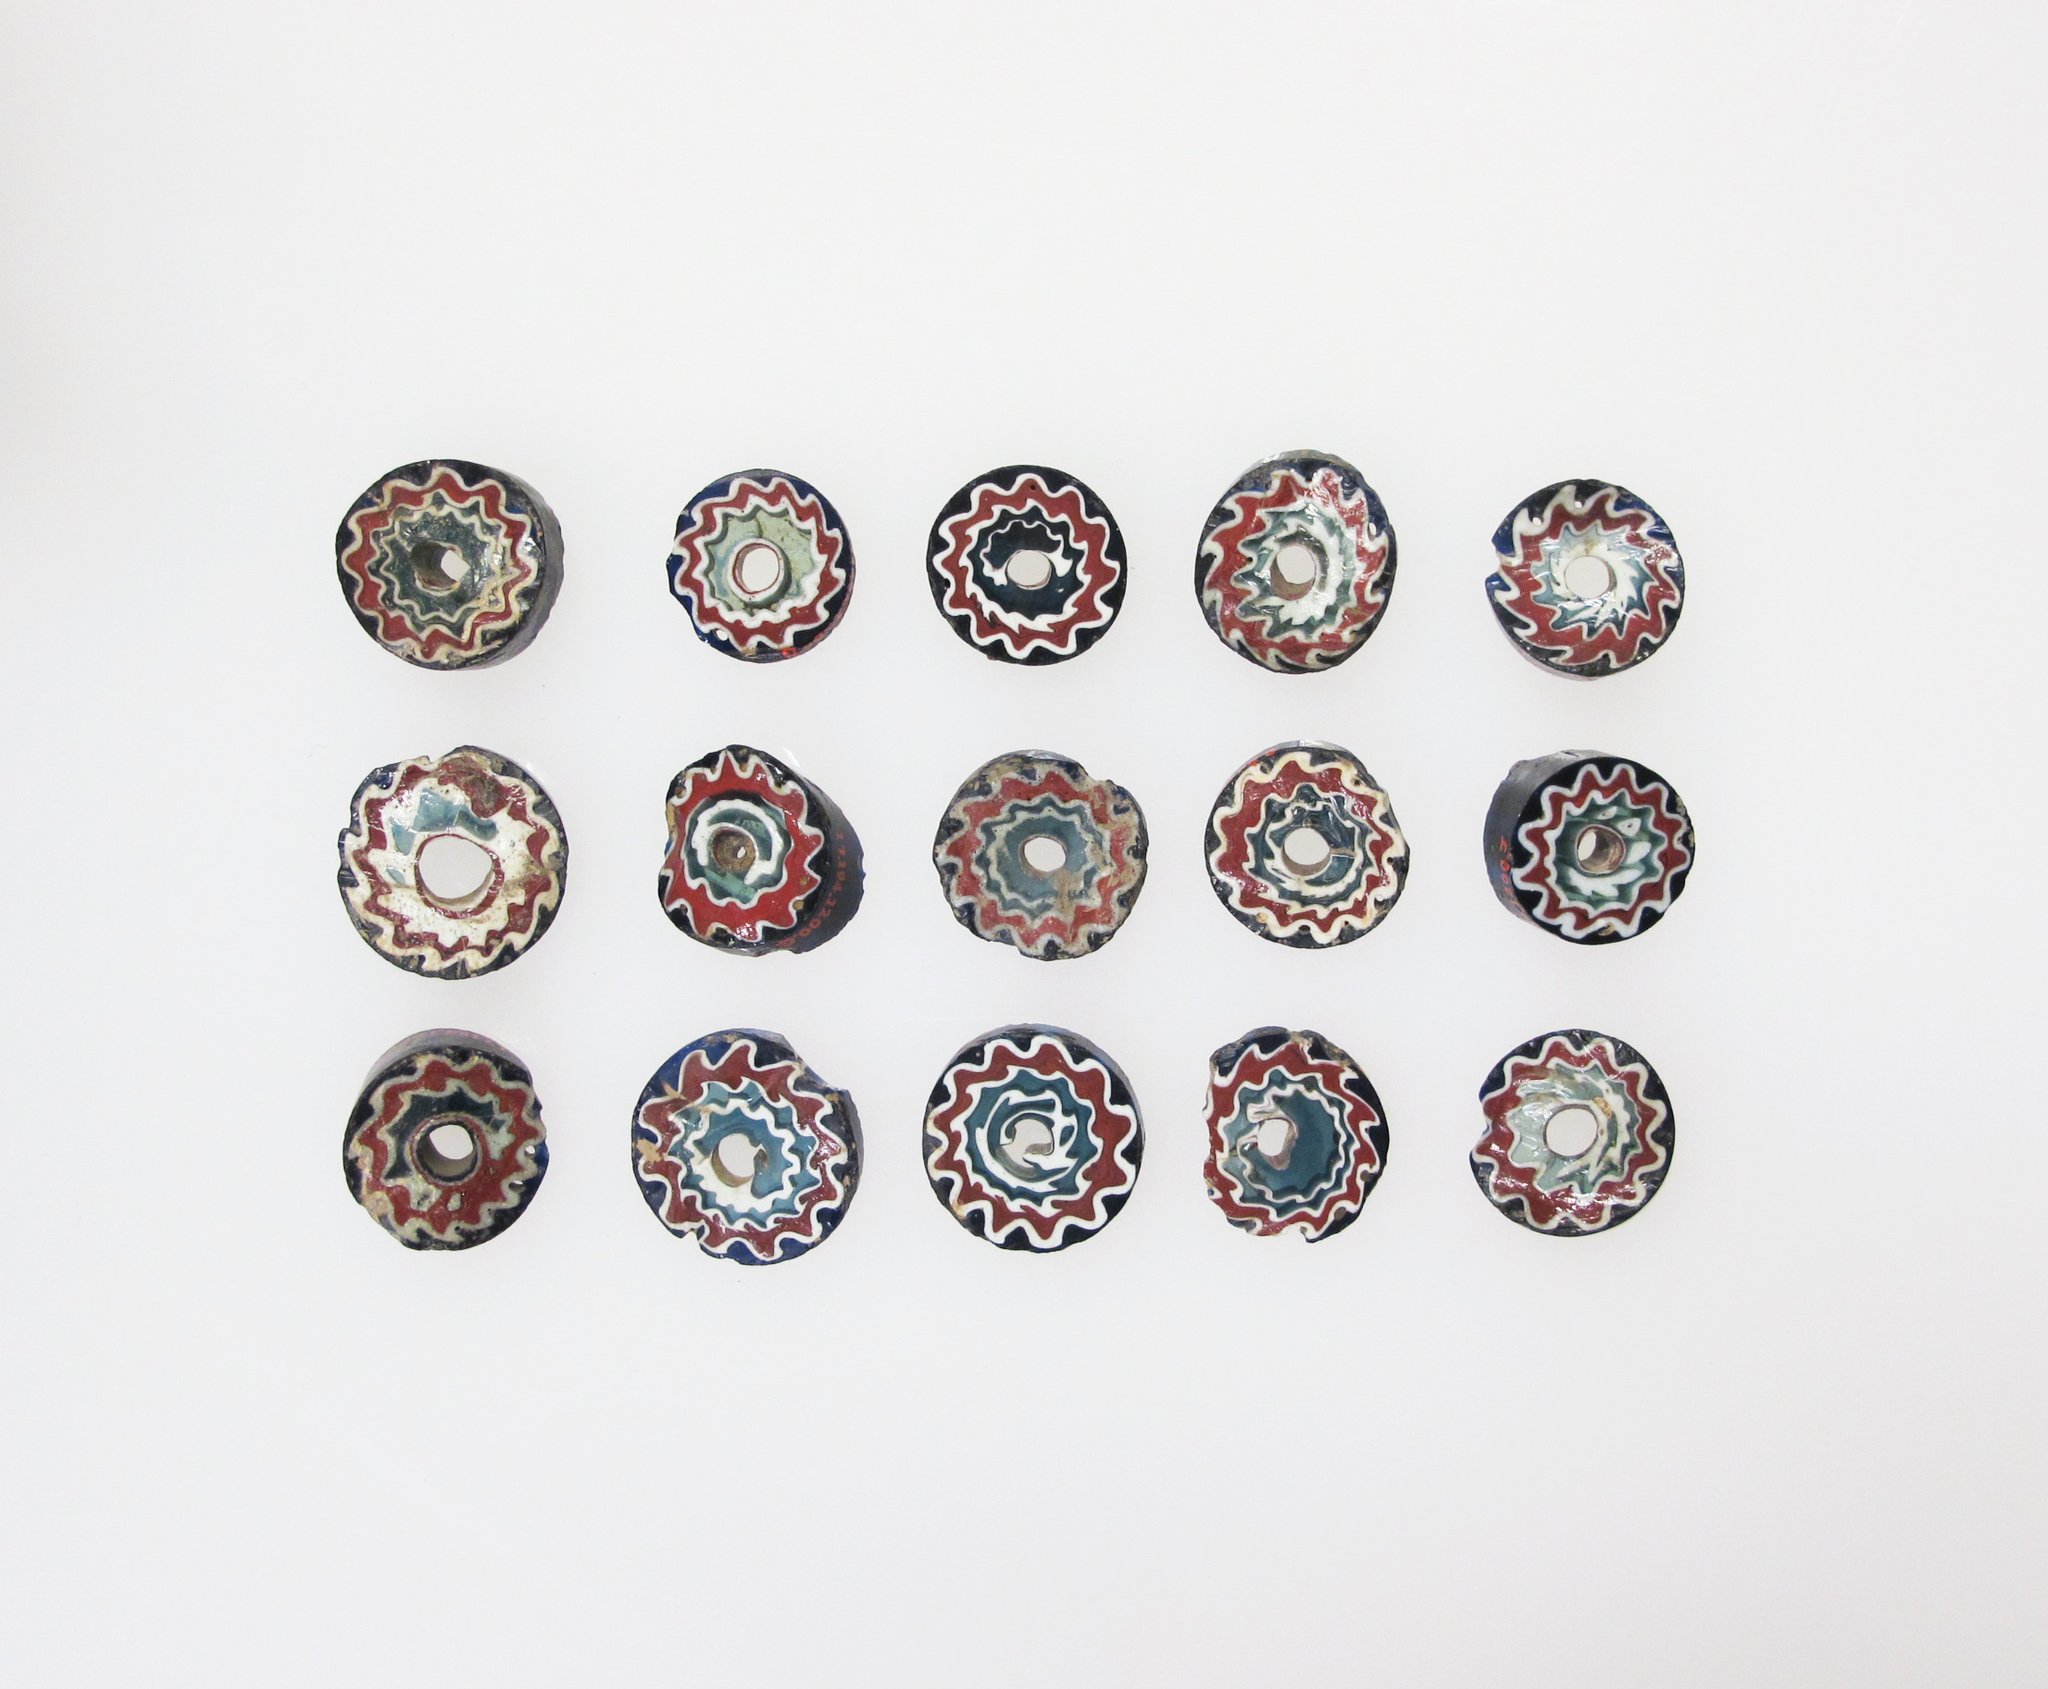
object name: millefiori bead rod, 15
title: Millefiori bead rods, 15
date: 7000 BCE-330 CE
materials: glass